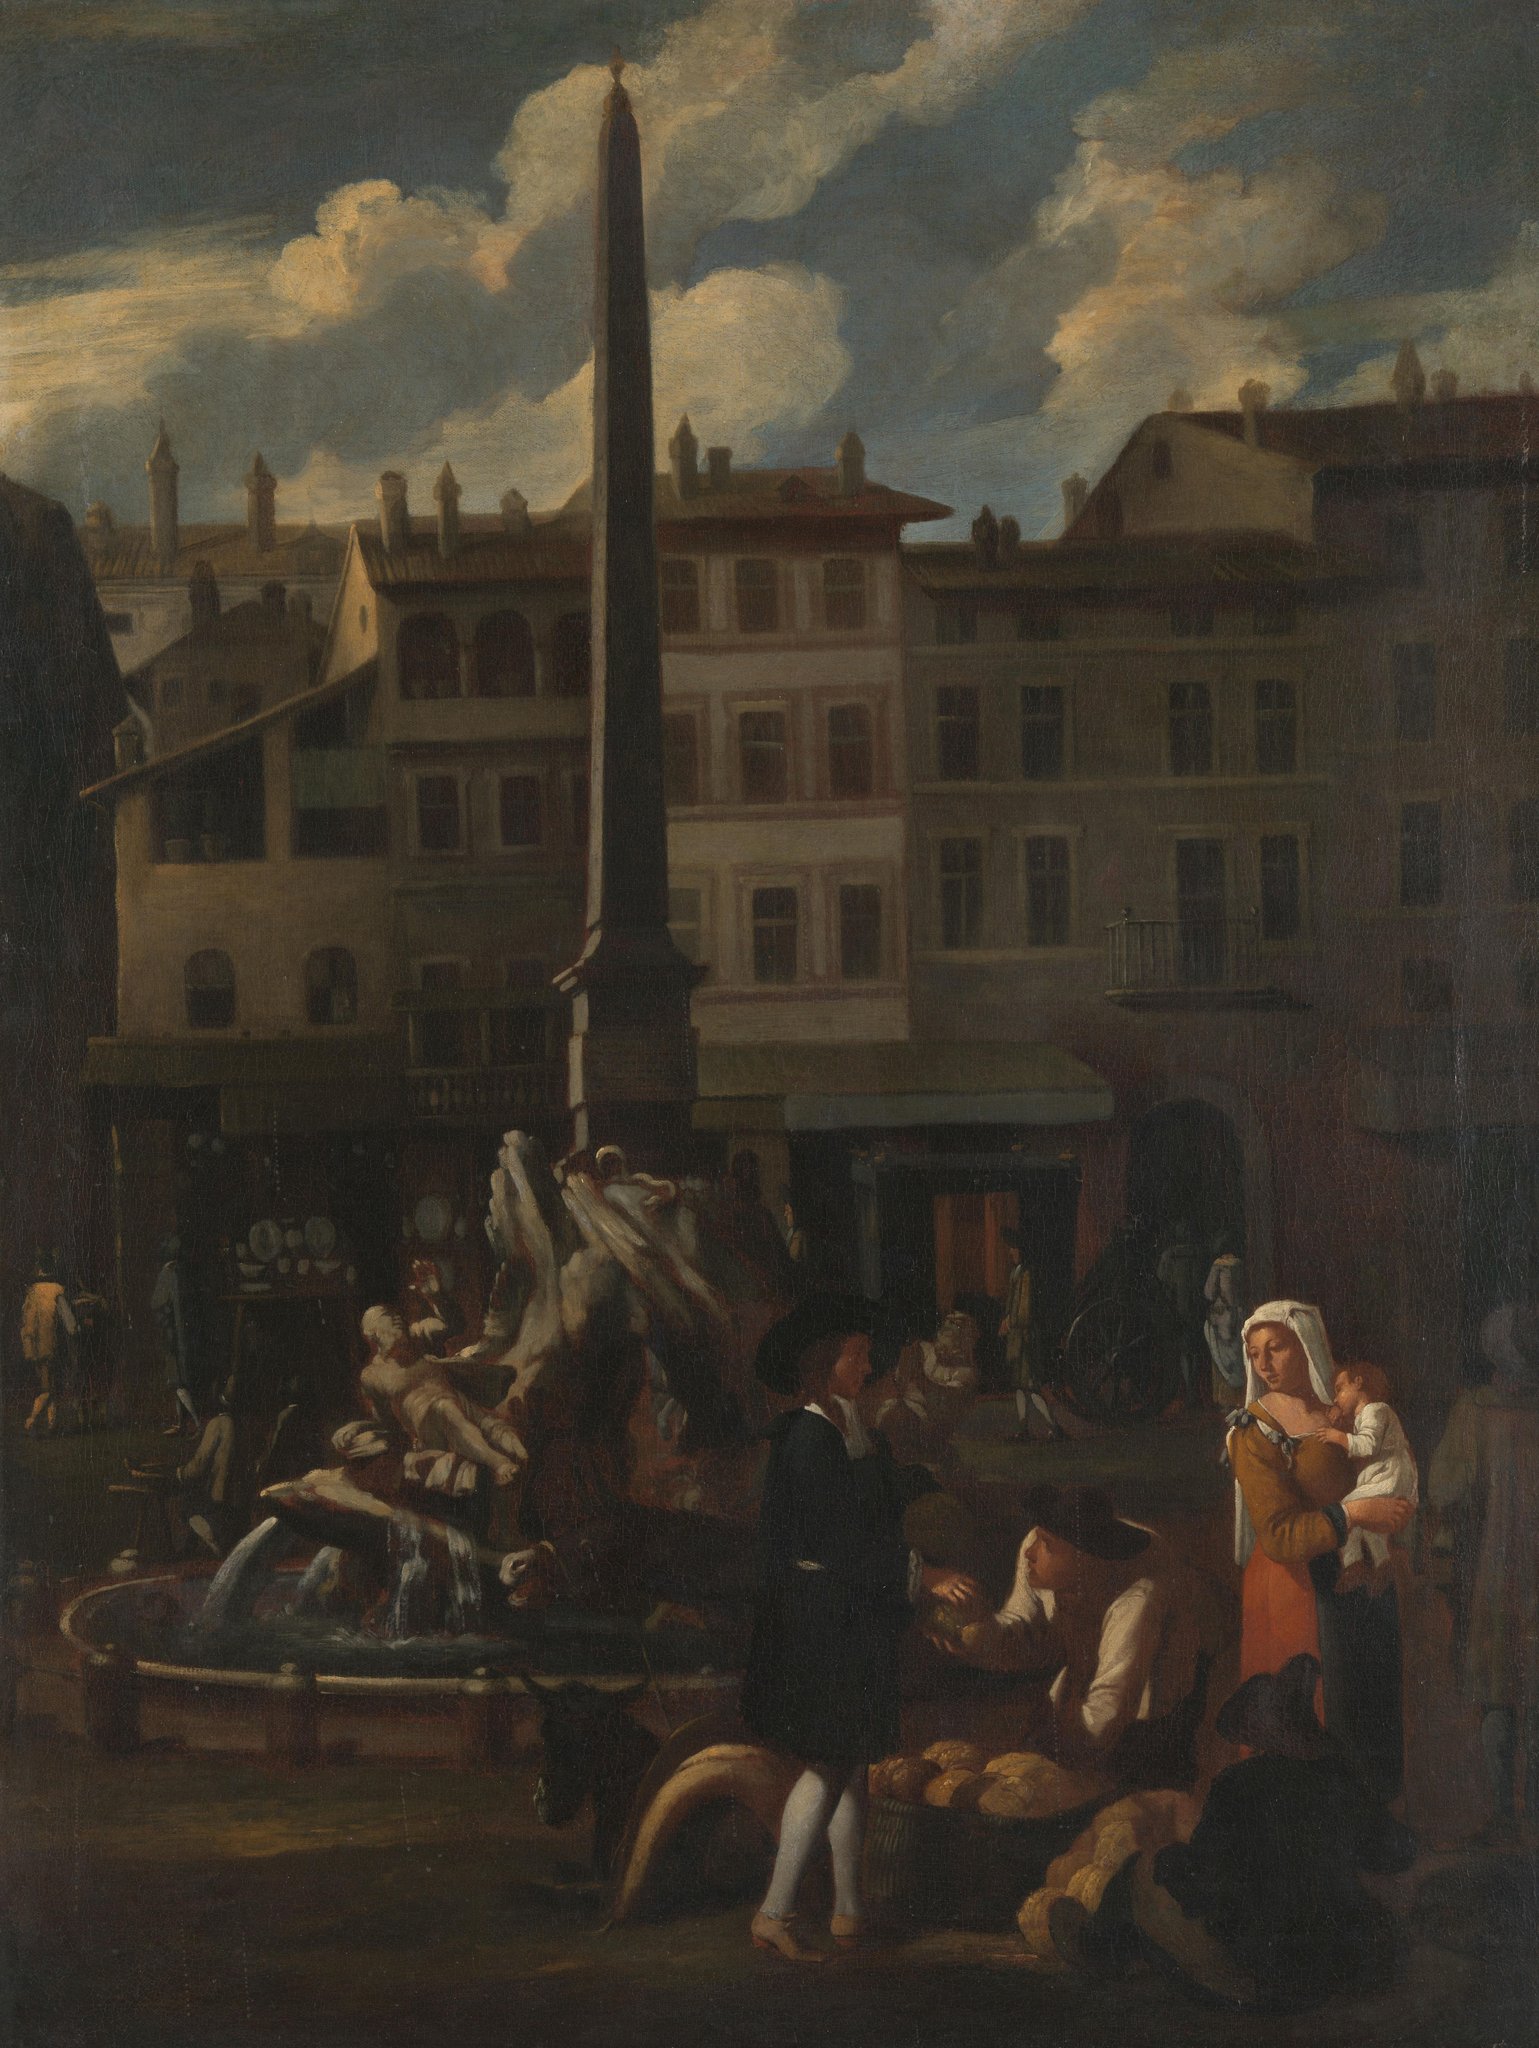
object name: painting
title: Market Scene in Rome, Piazza Navonna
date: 1650-1680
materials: canvas, oil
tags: market, ornamental fountain (+ city(-scape) with figures, staffage), rome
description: Markttafereel in Rome. Gezicht op de fontein Fontana dei quattro Fiumi op de Piazza Navona waar een man een brood van twee straathandelaren koopt, rechts een moeder met een kind op de arm.